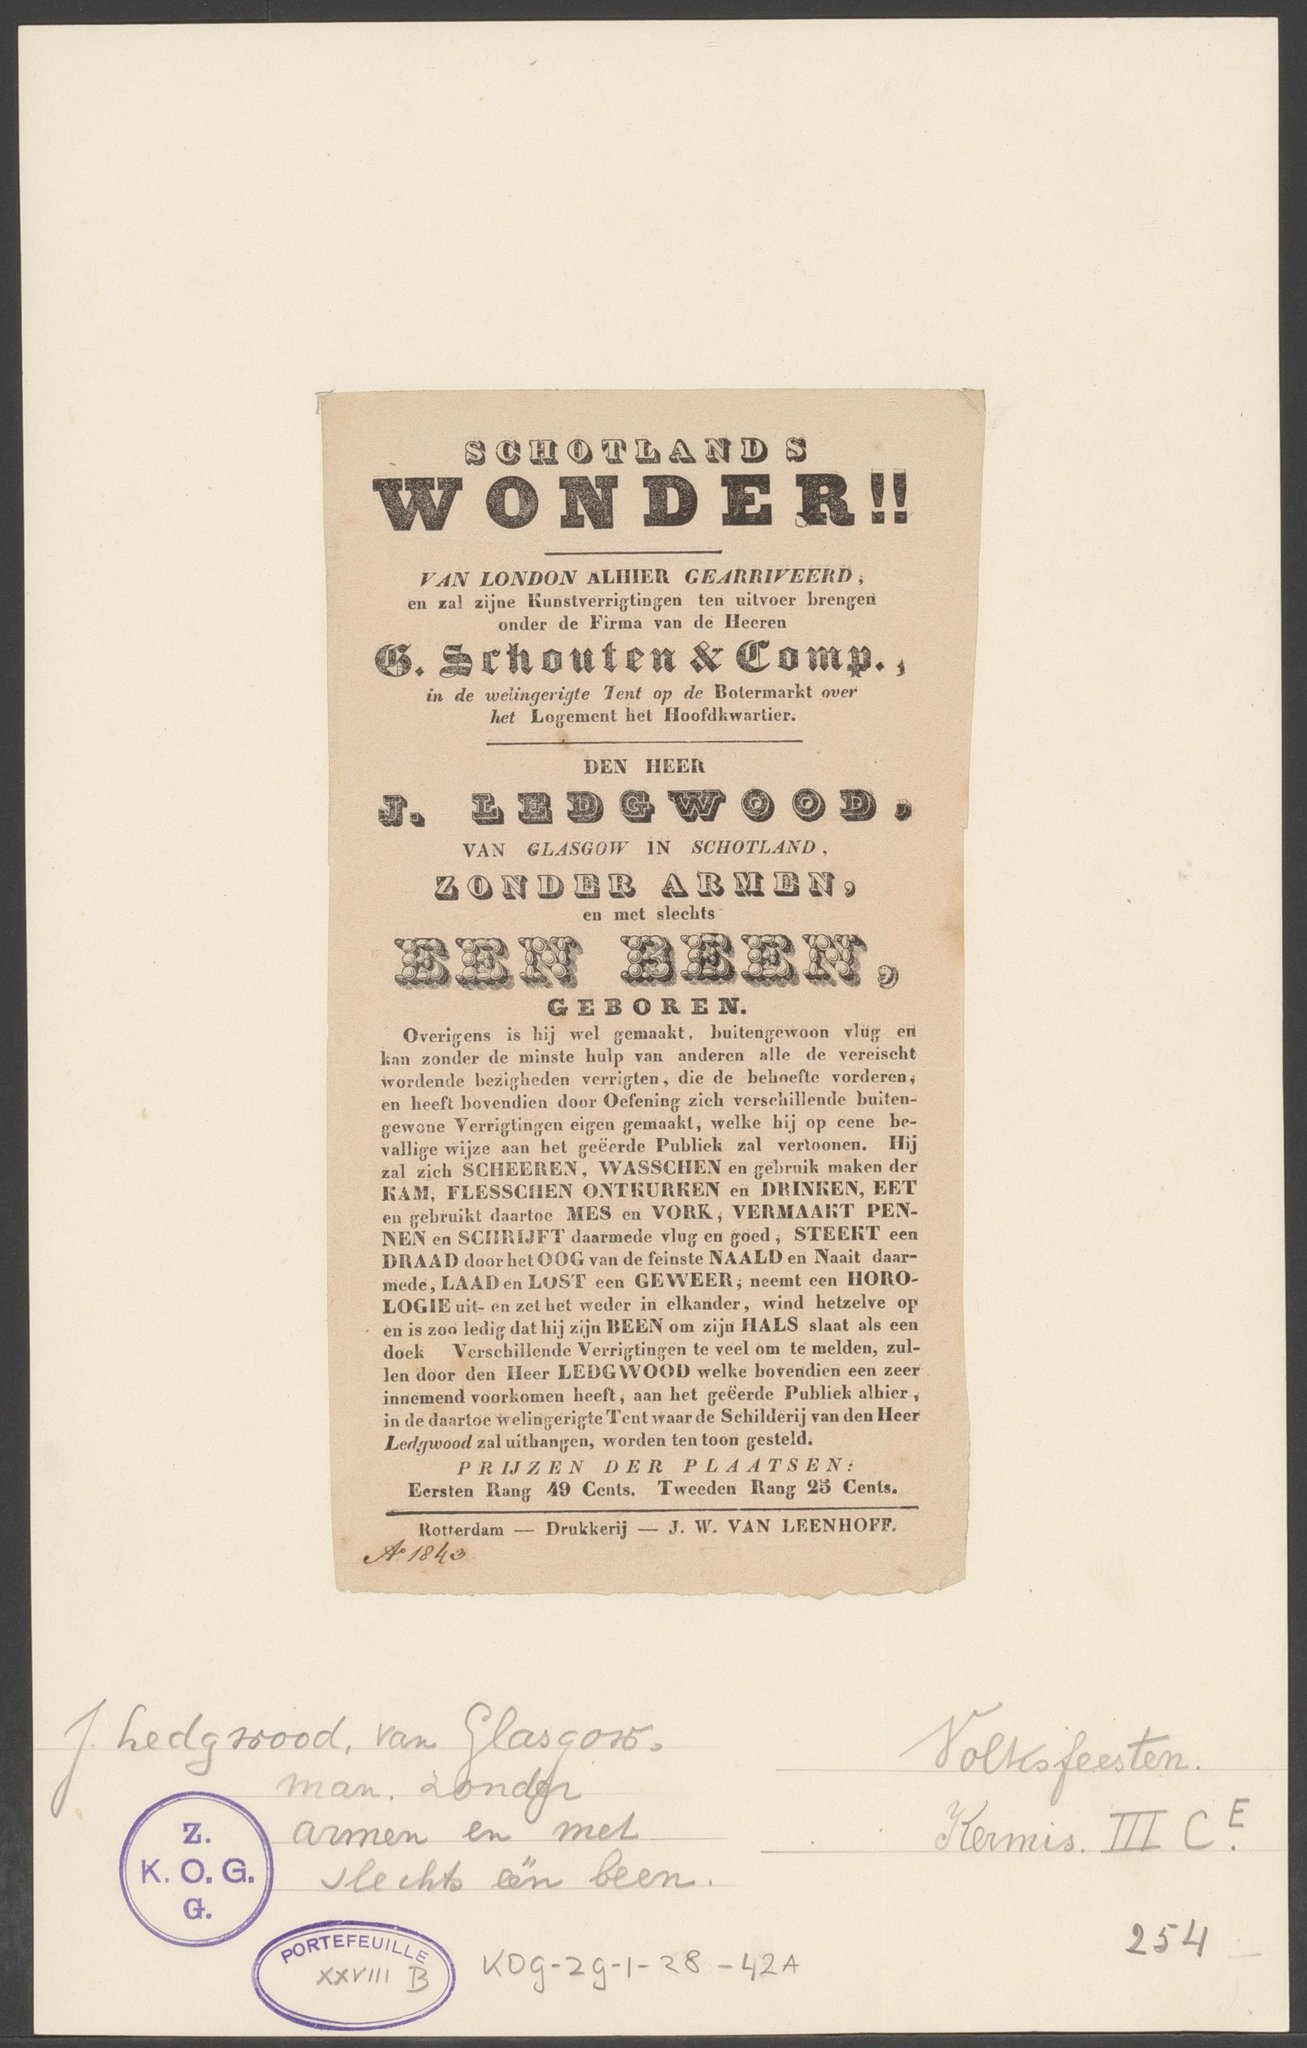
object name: text sheet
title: Schotlands wonder!!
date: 1840-1845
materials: paper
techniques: letterpress printing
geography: rotterdam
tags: human monstrosities ~ freak show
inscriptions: stamp, collector's mark: Lugt 1641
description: Aankondiging van J. Ledgwood's komst naar Rotterdam. Onderaan een beschrijving van wat hij kan doen zonder armen en met maar een been. Onderwerpsrubrieken binnen de Atlas Zeden en Gewoonten: Zeden en Gewoonten in Engeren Zin. Volksleven. Volksfeesten. Kermistypen, wondermenschen en dergelijken.